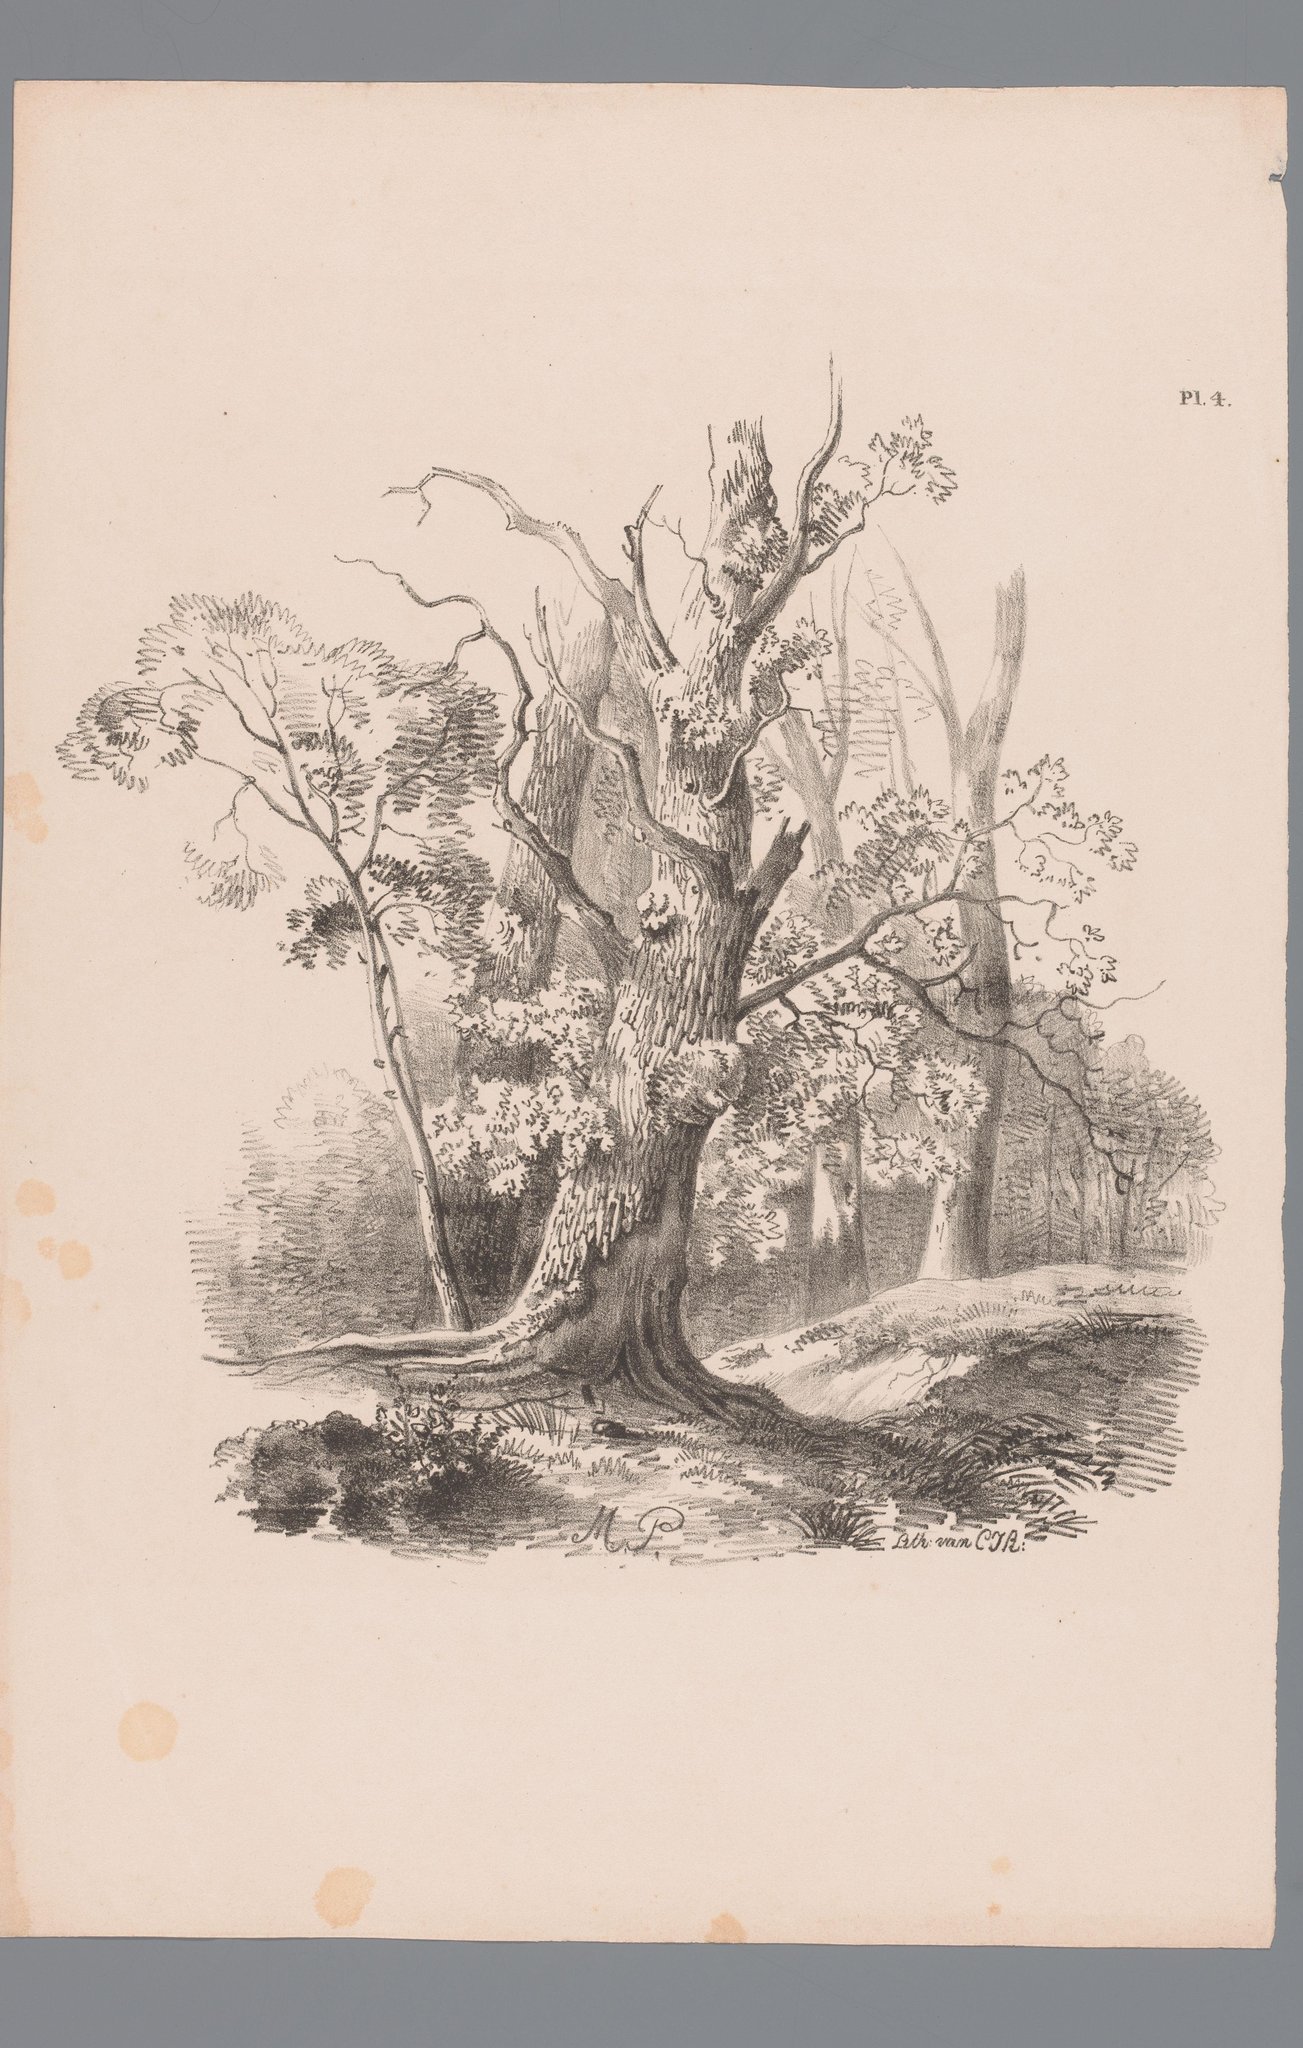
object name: print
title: Bosgezicht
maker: christiaan johannes reinhold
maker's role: steendrukker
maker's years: 1810-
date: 1838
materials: paper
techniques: lithograph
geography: amsterdam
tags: forest, wood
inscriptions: collector's mark: Lugt 2228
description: Onderdeel van een omslag met een serie van vier Gelderse landschappen.